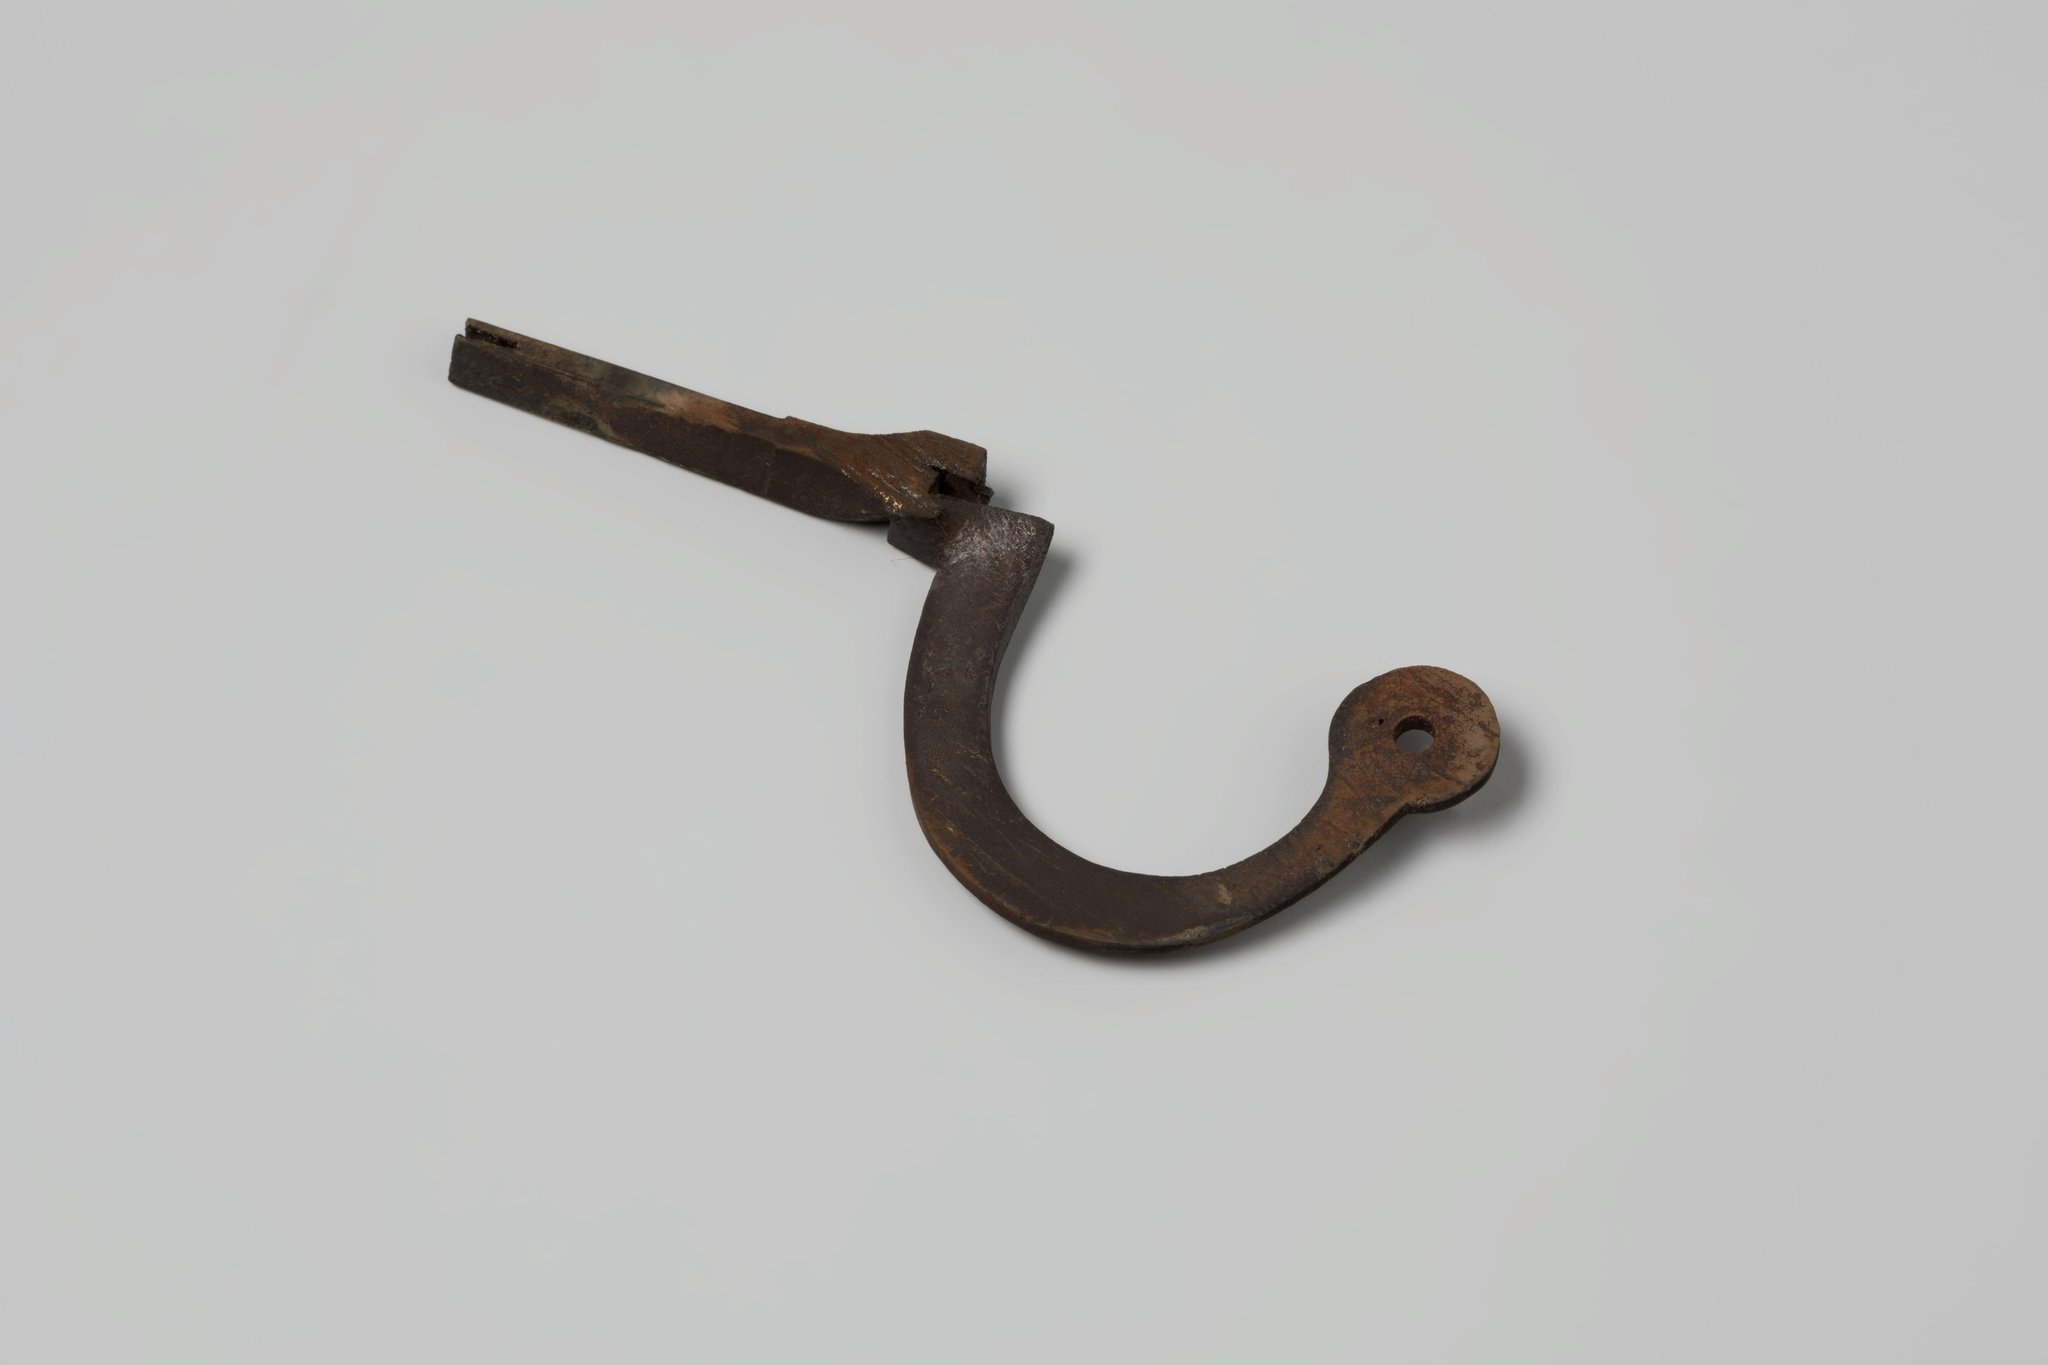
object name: divider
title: Fragment steekpasser uit het wrak van de Oost-Indiëvaarder Hollandia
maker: Anonymous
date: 1700-1743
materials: copper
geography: netherlands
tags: verenigde oostindische compagnie, hollandia (schip), annet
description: Divider; fragment, leg: tapering, three-faceted, with one of bifid rings (id. NG 1980-27H1223), twisted 45 degrees, semicircular, flat in section, tapering toward pierced circular end (acting as pivot).